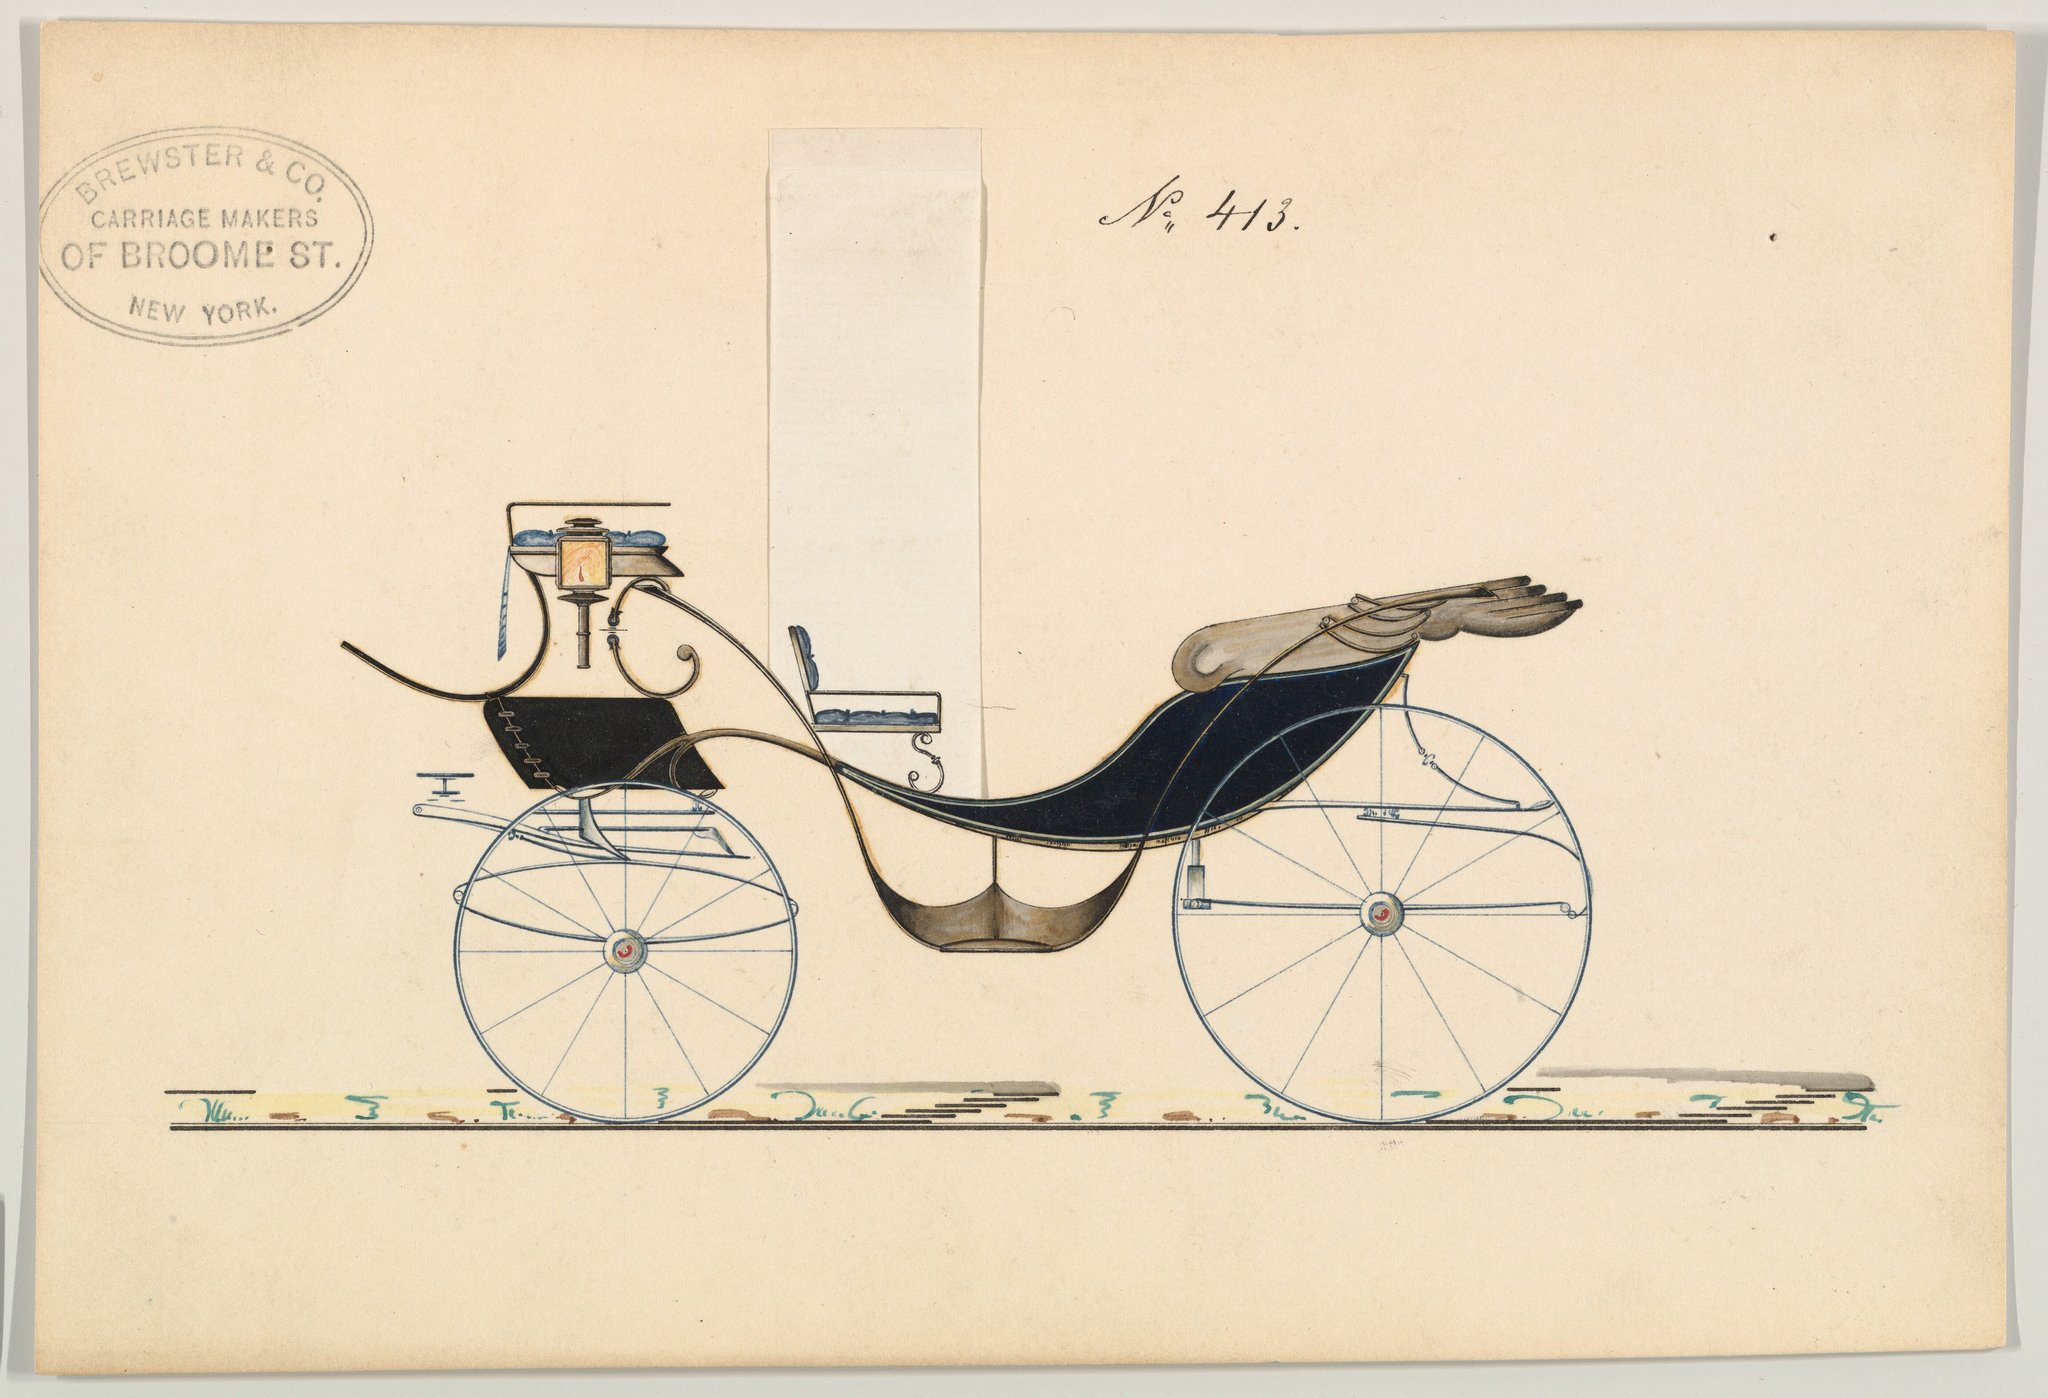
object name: drawing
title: Victoria #413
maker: brewster & co.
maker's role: manufacturer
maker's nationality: american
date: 1860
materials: gouache, gum arabic, ink, watercolor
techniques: pen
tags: carriages